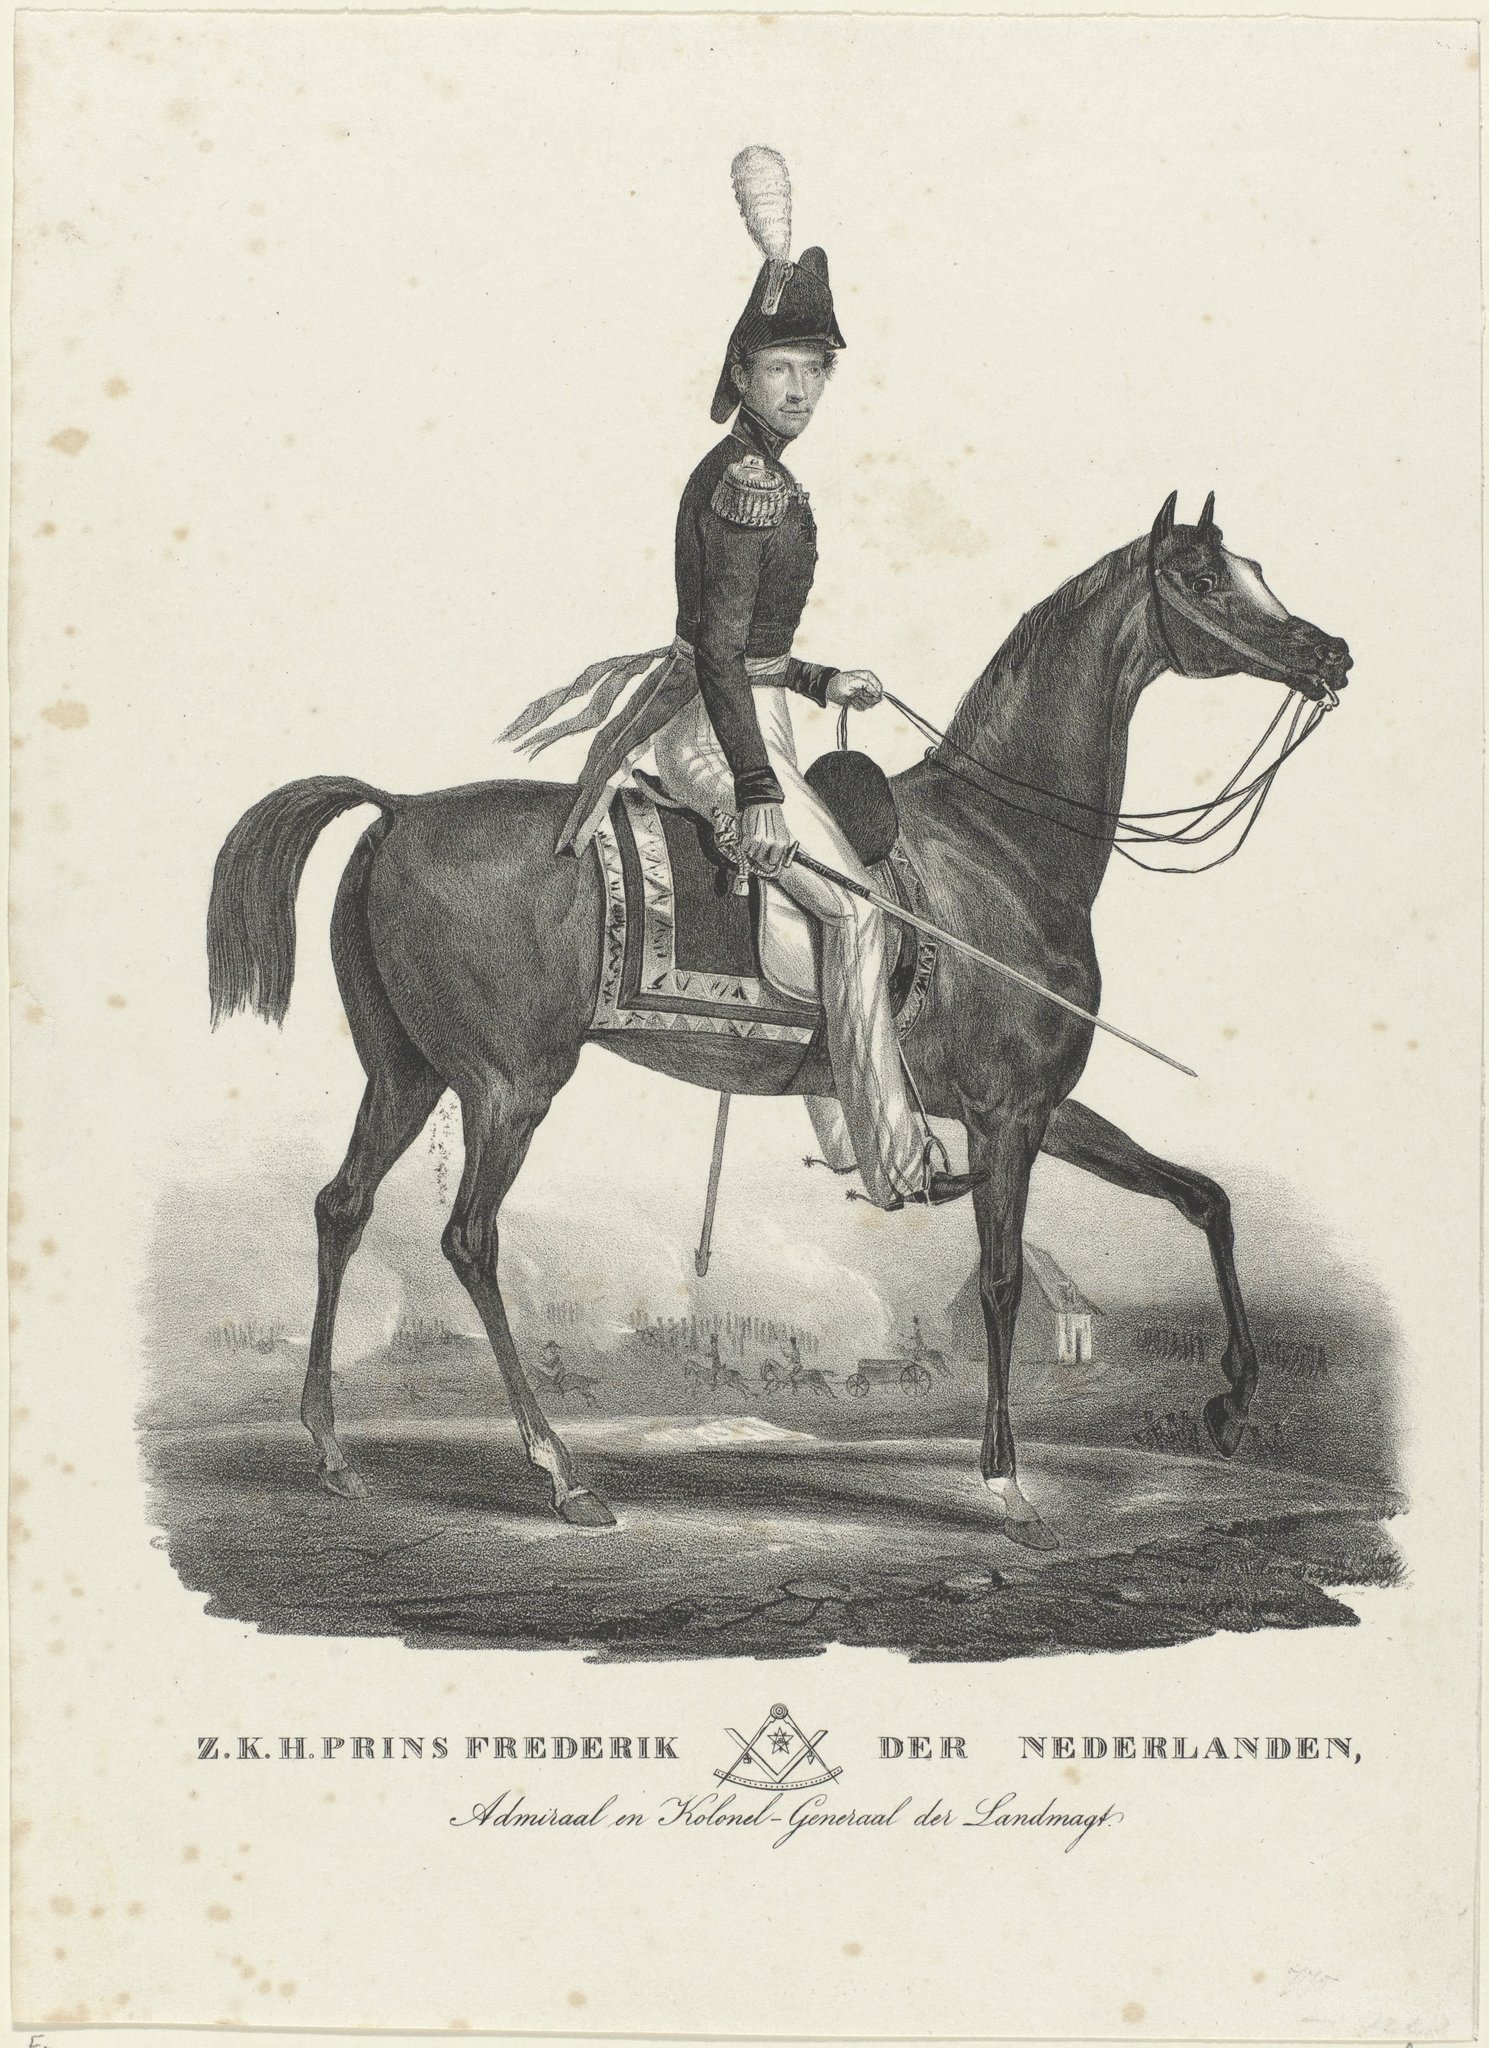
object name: print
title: Ruiterportret van Frederik, prins der Nederlanden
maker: Anonymous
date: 1816-1871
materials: paper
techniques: lithograph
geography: netherlands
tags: berlin, frederik (prins der nederlanden)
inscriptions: collector's mark: Lugt 963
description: Ruiterportret van Frederik met een hoed. Op de achtergrond een veldslag. Midden onder attributen en symbolen van de vrijmetselaars. In de ondermarge zijn naam en titels.